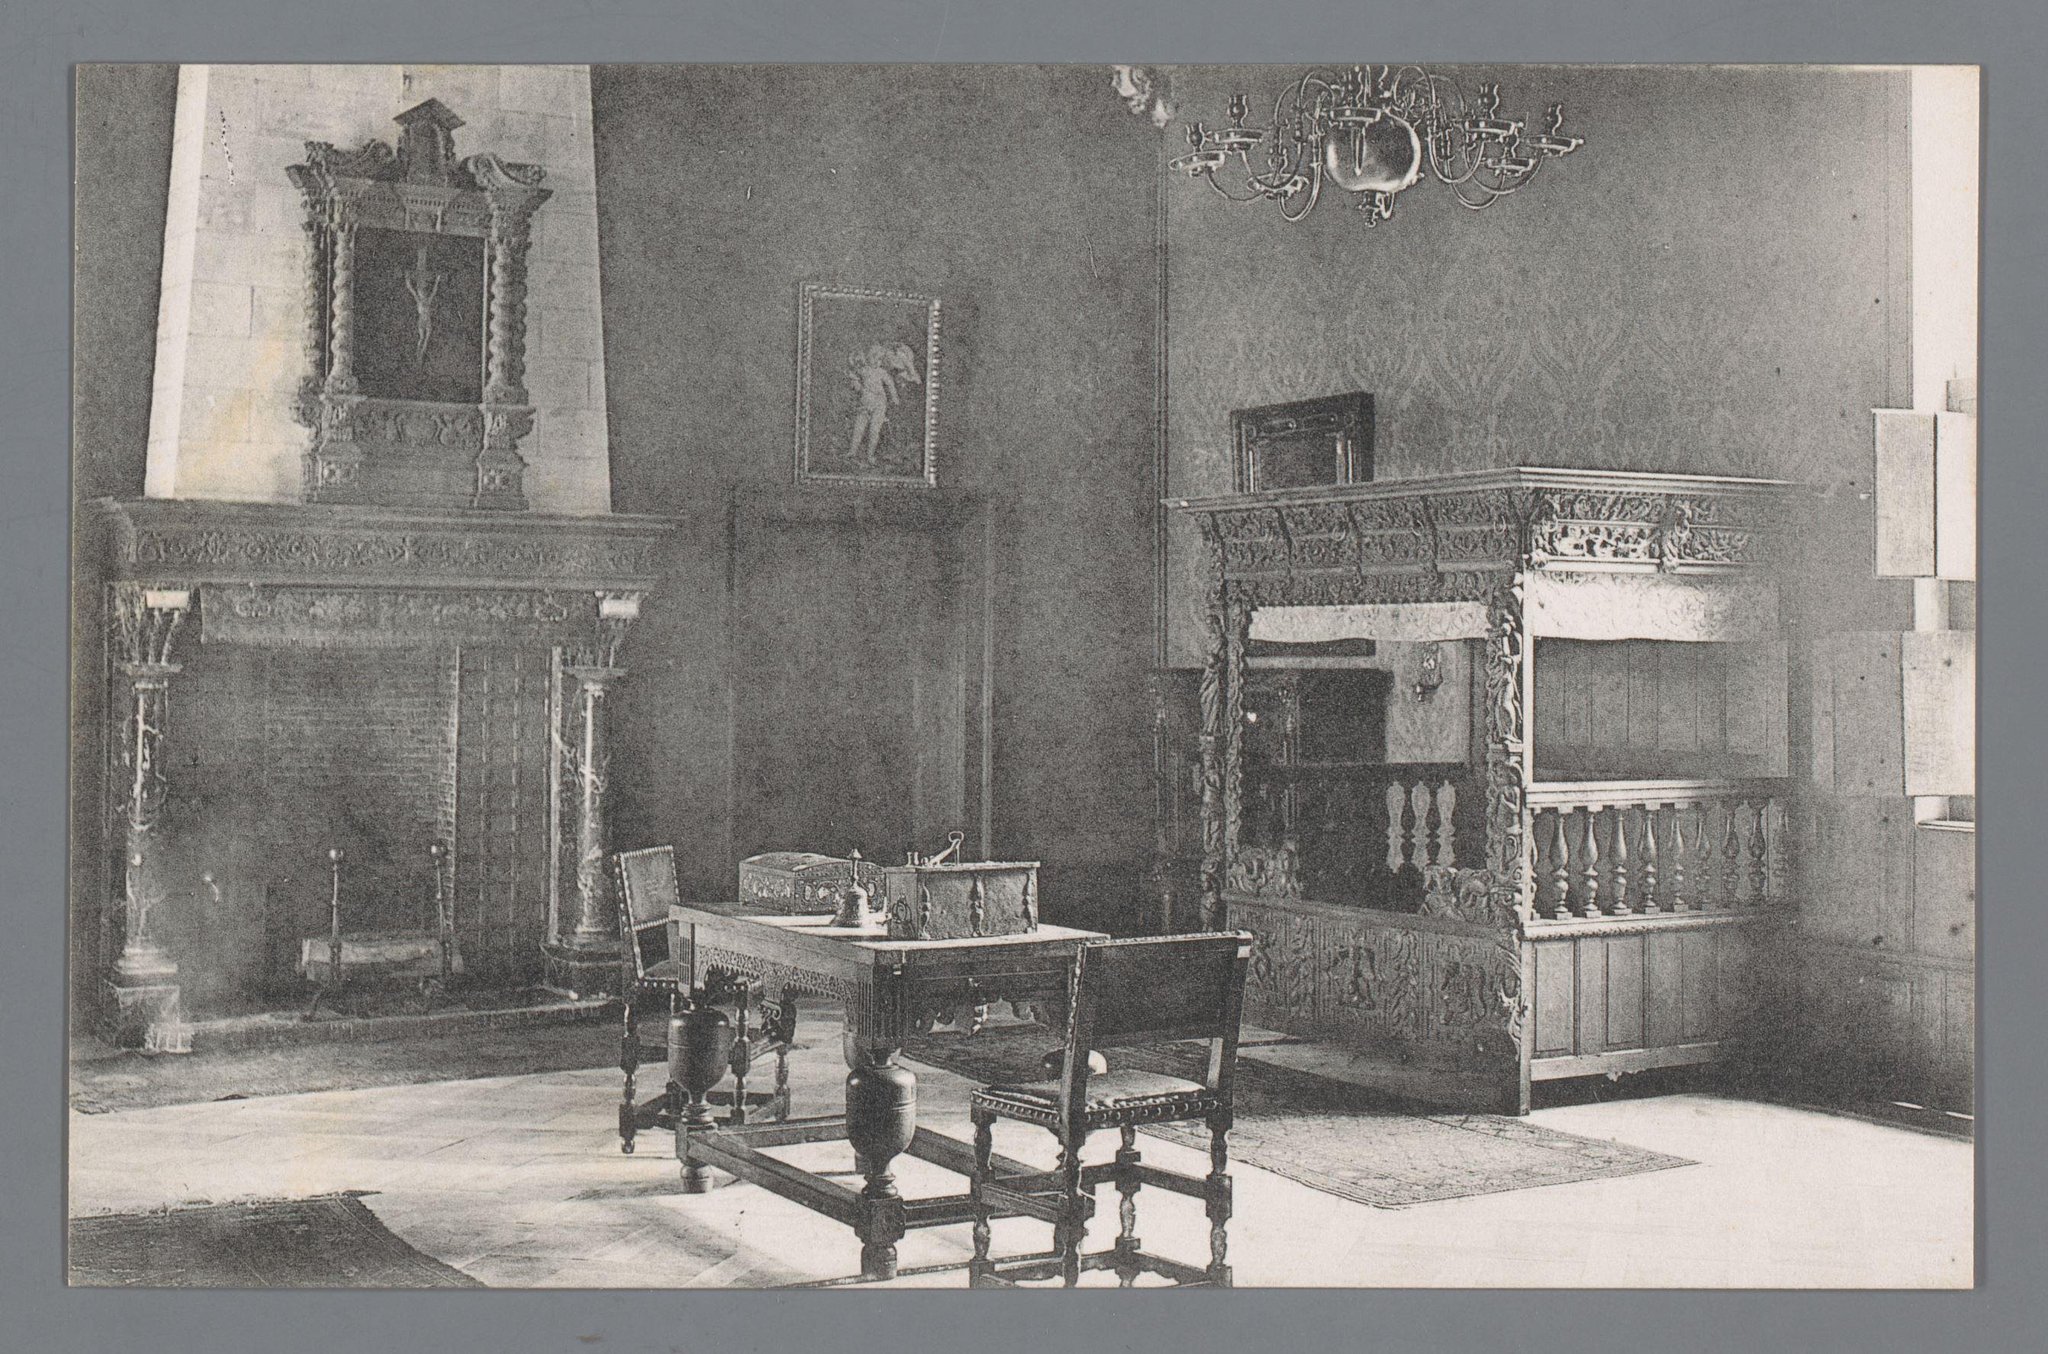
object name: ansichtkaart, prentbriefkaart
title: Exposition d'Art Ancien "Le XVIIme siècle"... ...Bruxelles 1910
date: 1910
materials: paper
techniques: photography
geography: brussels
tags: brussels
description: Briefkaart, zwart-wit: Interieurs tentoonstelling over de 17de eeuw.